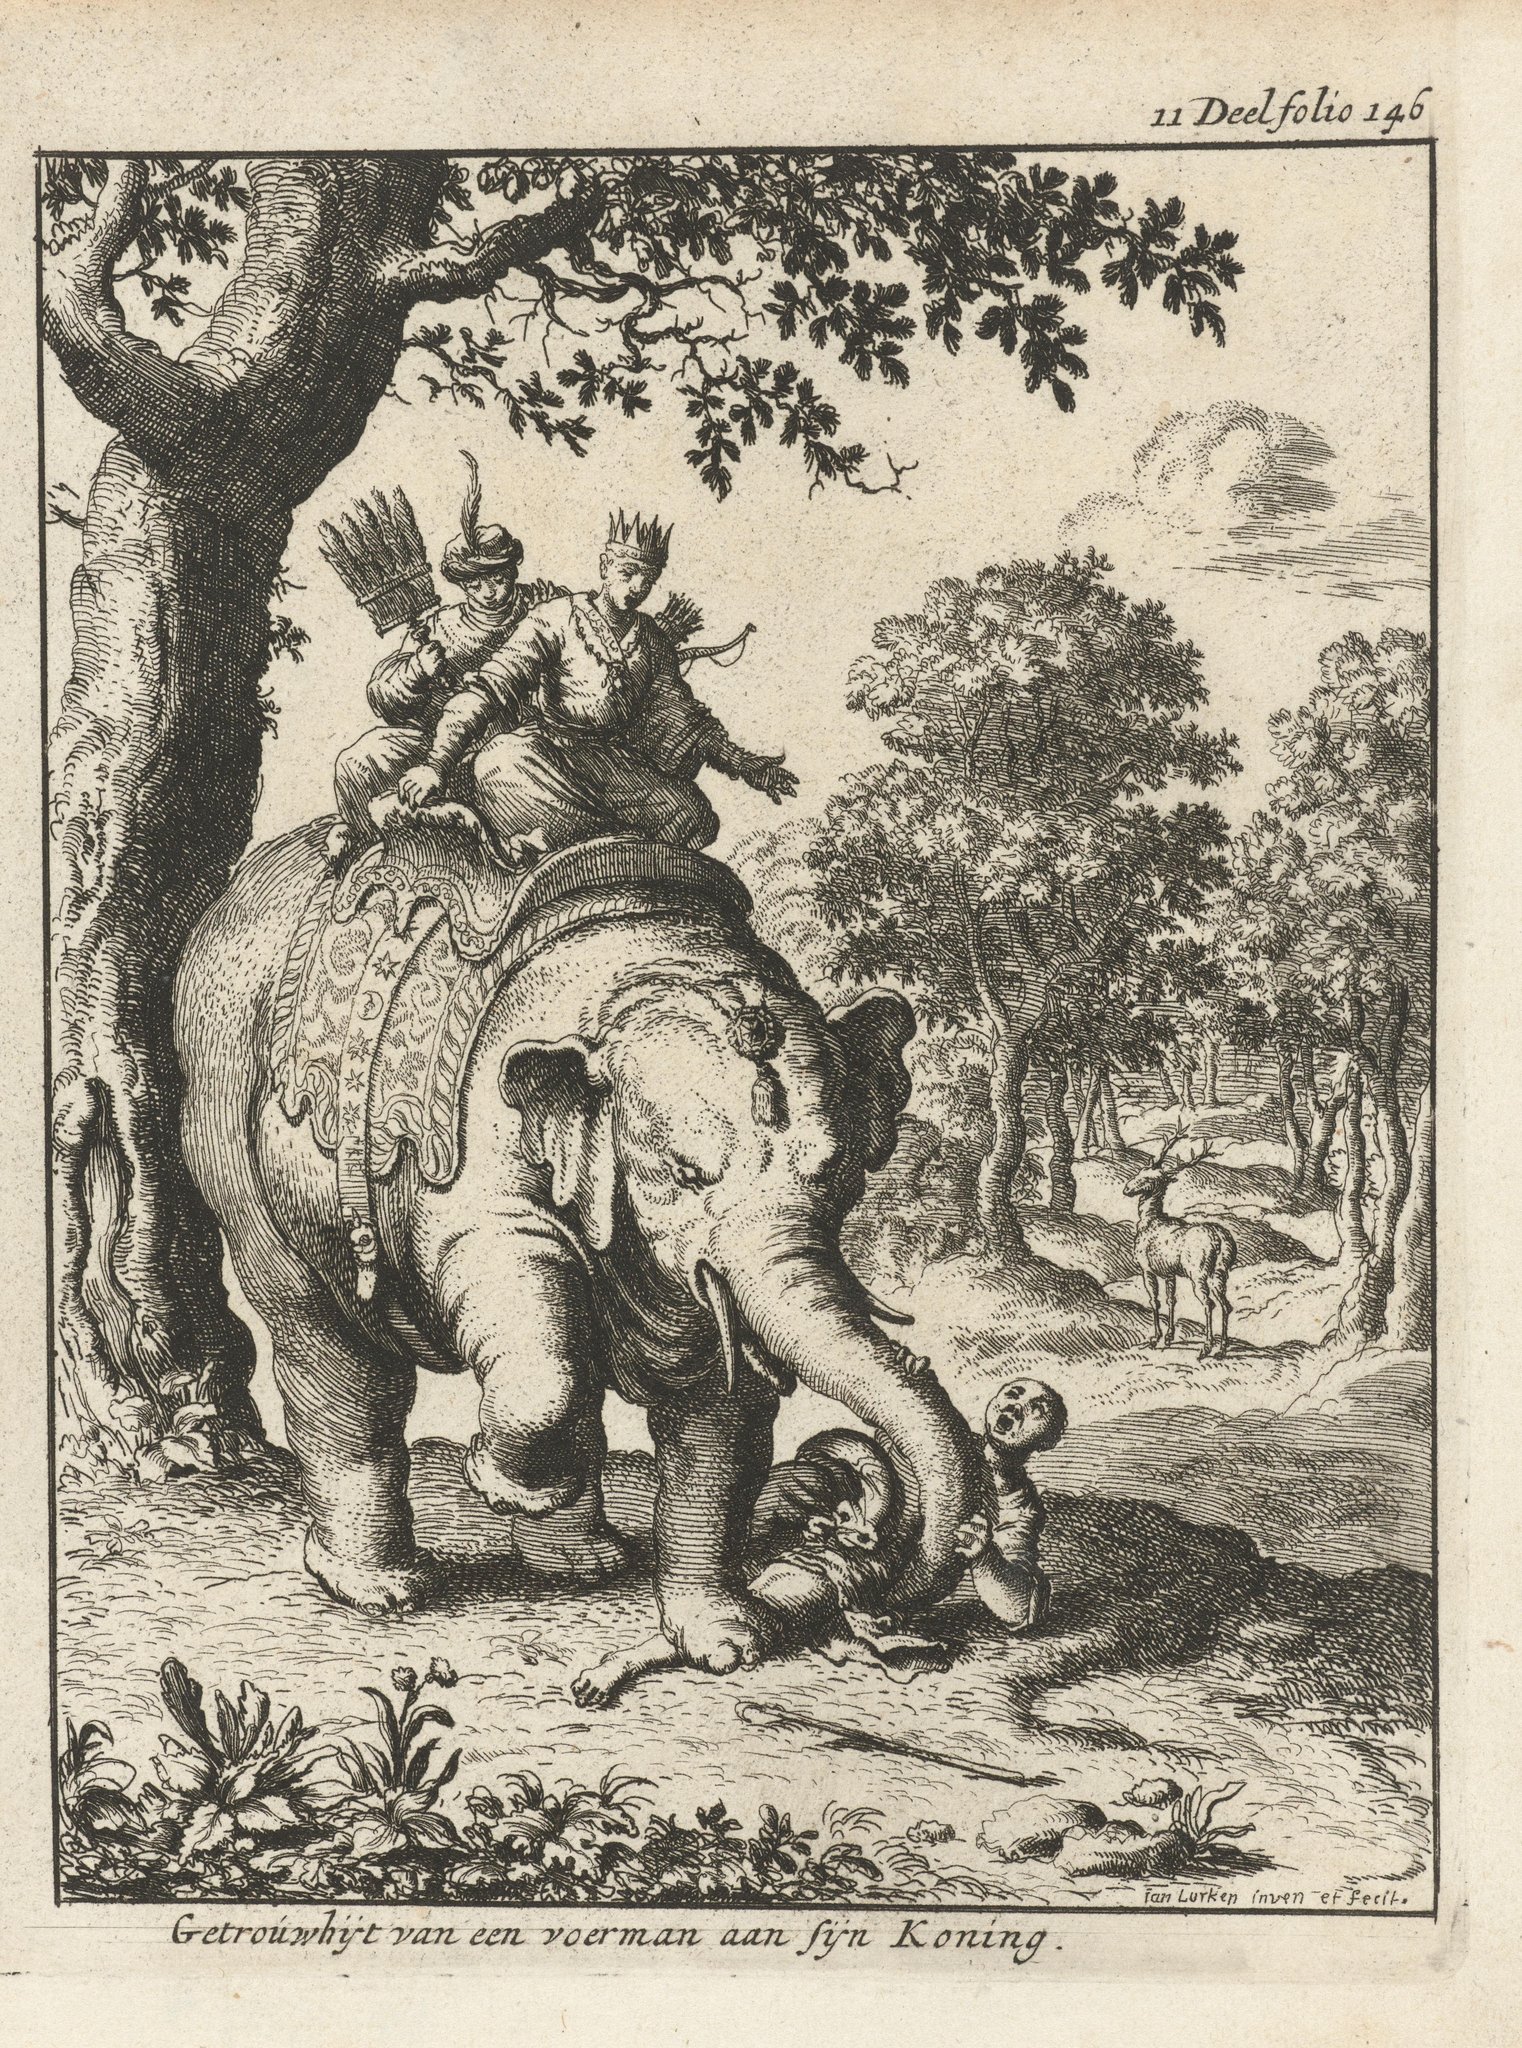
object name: book illustration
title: Olifant vertrapt zijn oppasser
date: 1682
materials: paper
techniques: etching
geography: amsterdam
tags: trunked animals (with name) (+ animal riding), servant, ruler, sovereign, animal killing man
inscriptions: collector's mark: Lugt 2228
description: Illustratie opgenomen in: Tavernier, Jean Baptiste. De Zes Reizen, 3 delen. Amsterdam: weduwe Joannes van Someren, 1682, dl. 2.